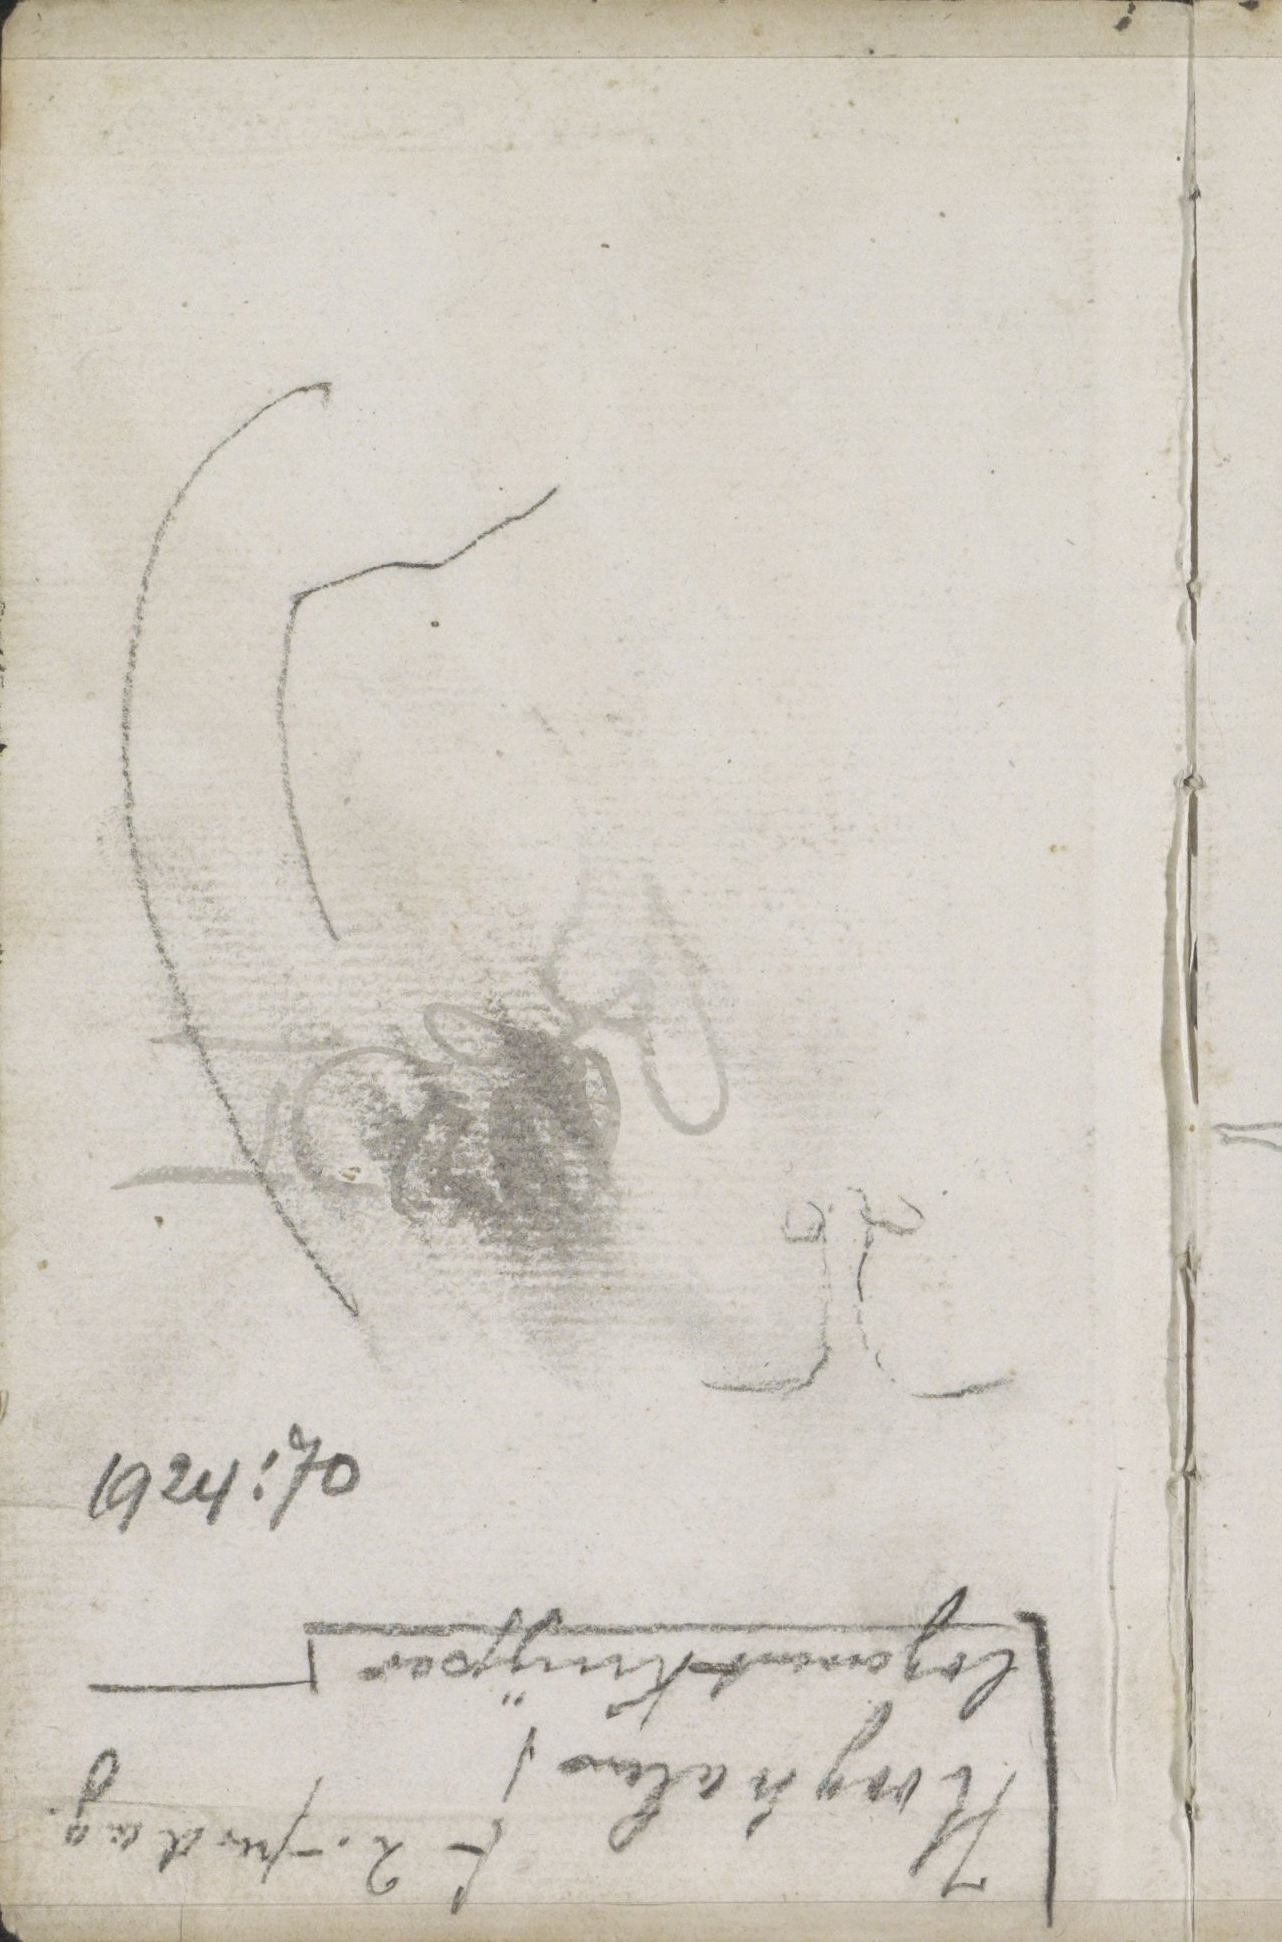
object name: endleaf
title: Studies en annotaties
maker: george hendrik breitner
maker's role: draughtsman, painter, print maker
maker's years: 1857-1923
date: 1884-1886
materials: chalk, paper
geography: drenthe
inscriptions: annotation: ‘f 2.- per dag./ Hooghalen/ logement Kuijper’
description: Pagina 1, voorste schutblad, uit een schetsboek met 67 bladen vervaardigd in Drenthe.